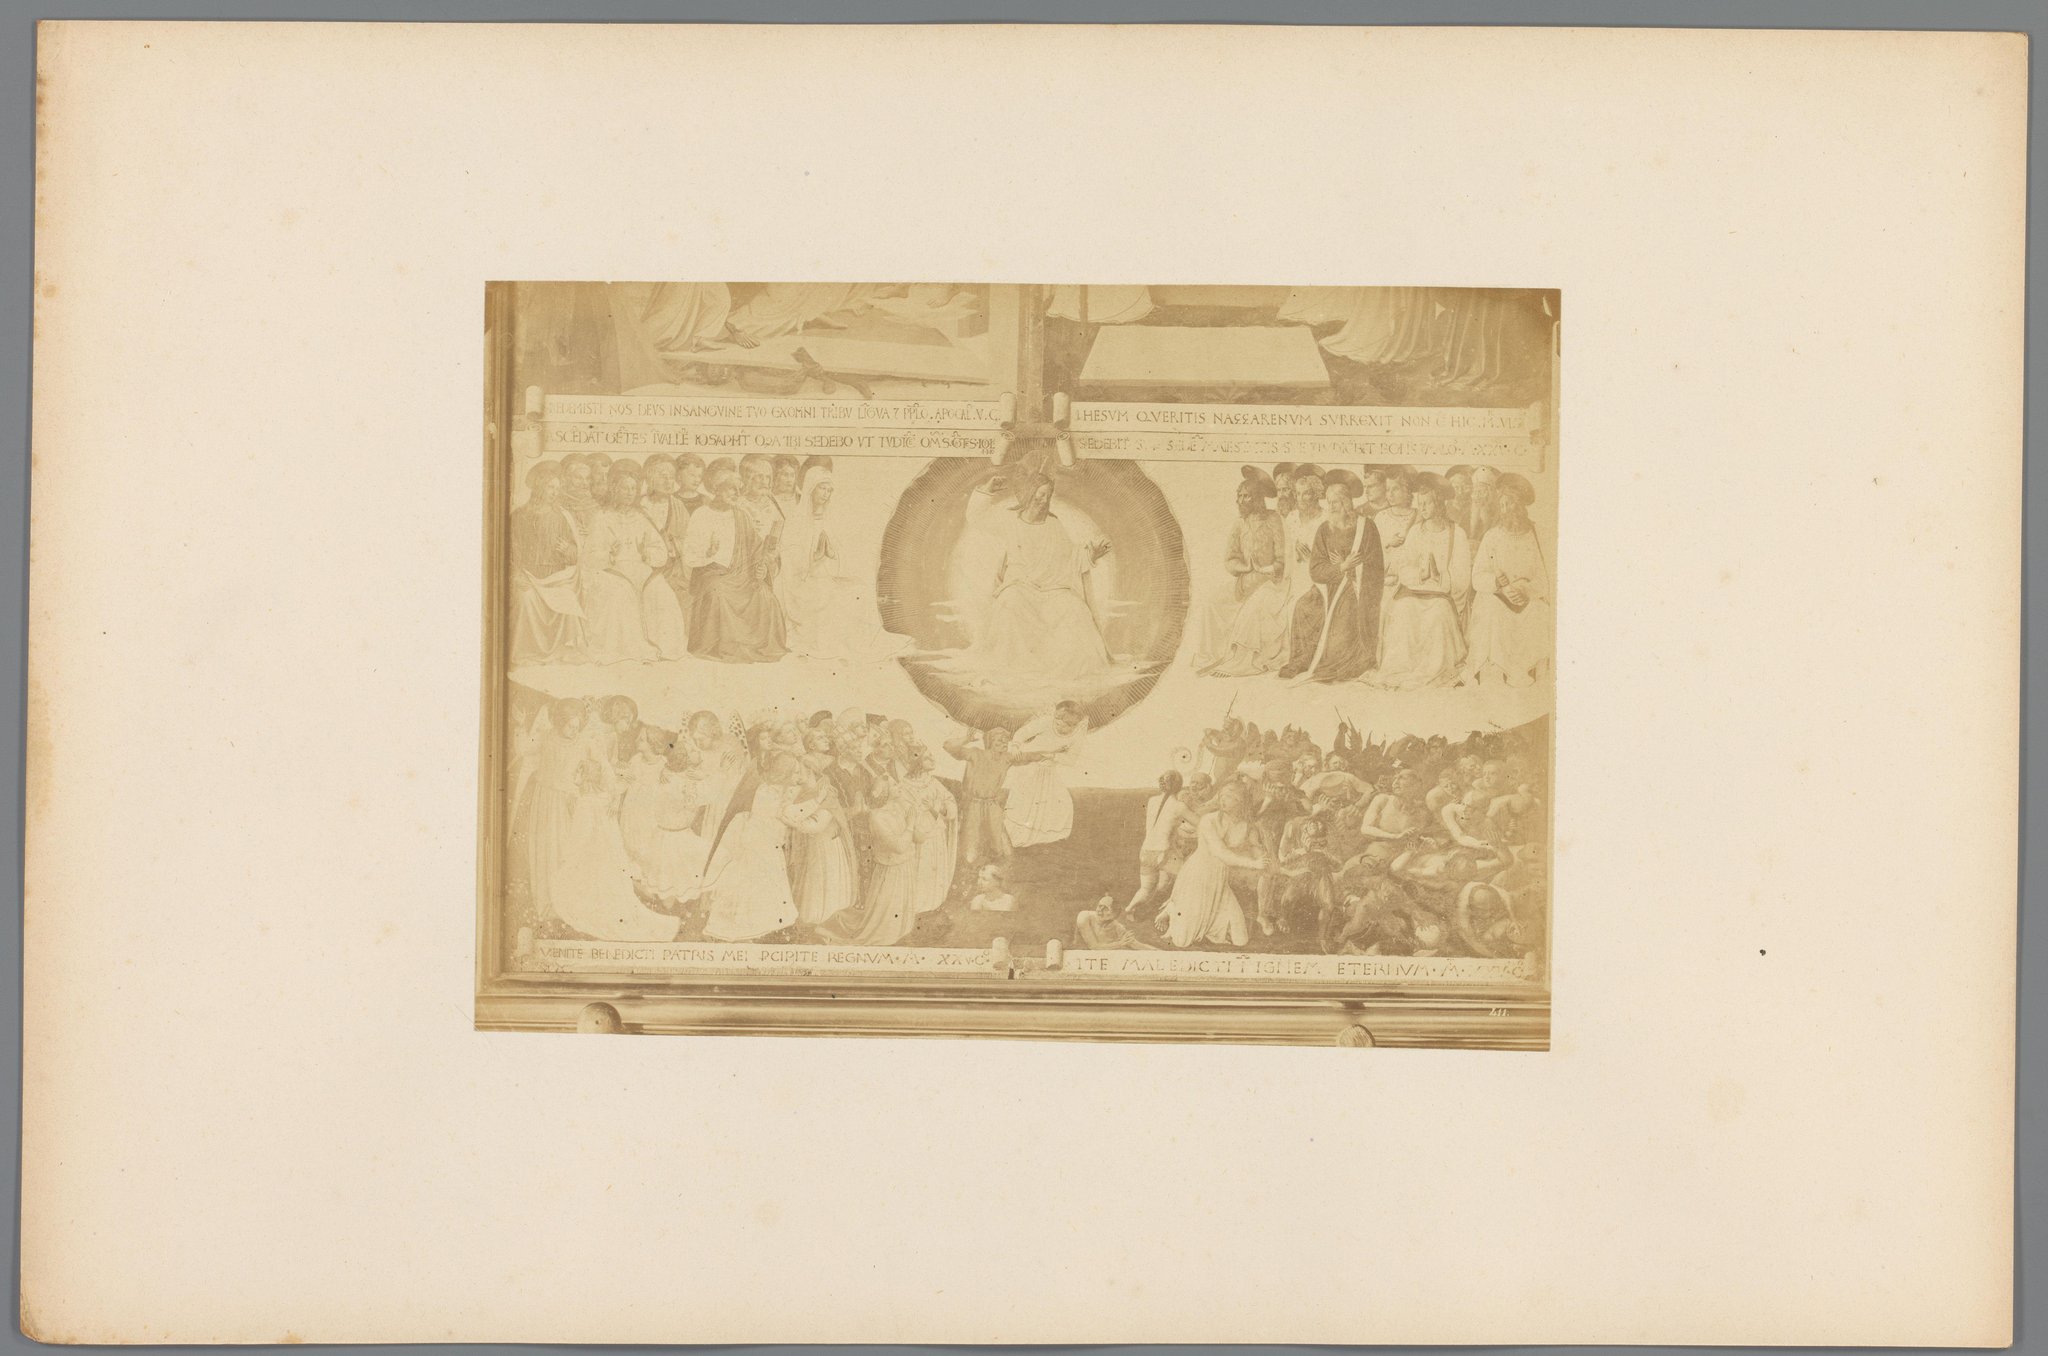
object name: photograph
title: Fotoreproductie van een schilderij voorstellende het laatste oordeel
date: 1857-1900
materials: cardboard, paper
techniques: albumen print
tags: picture, painting, wall-covering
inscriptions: number: ‘411’